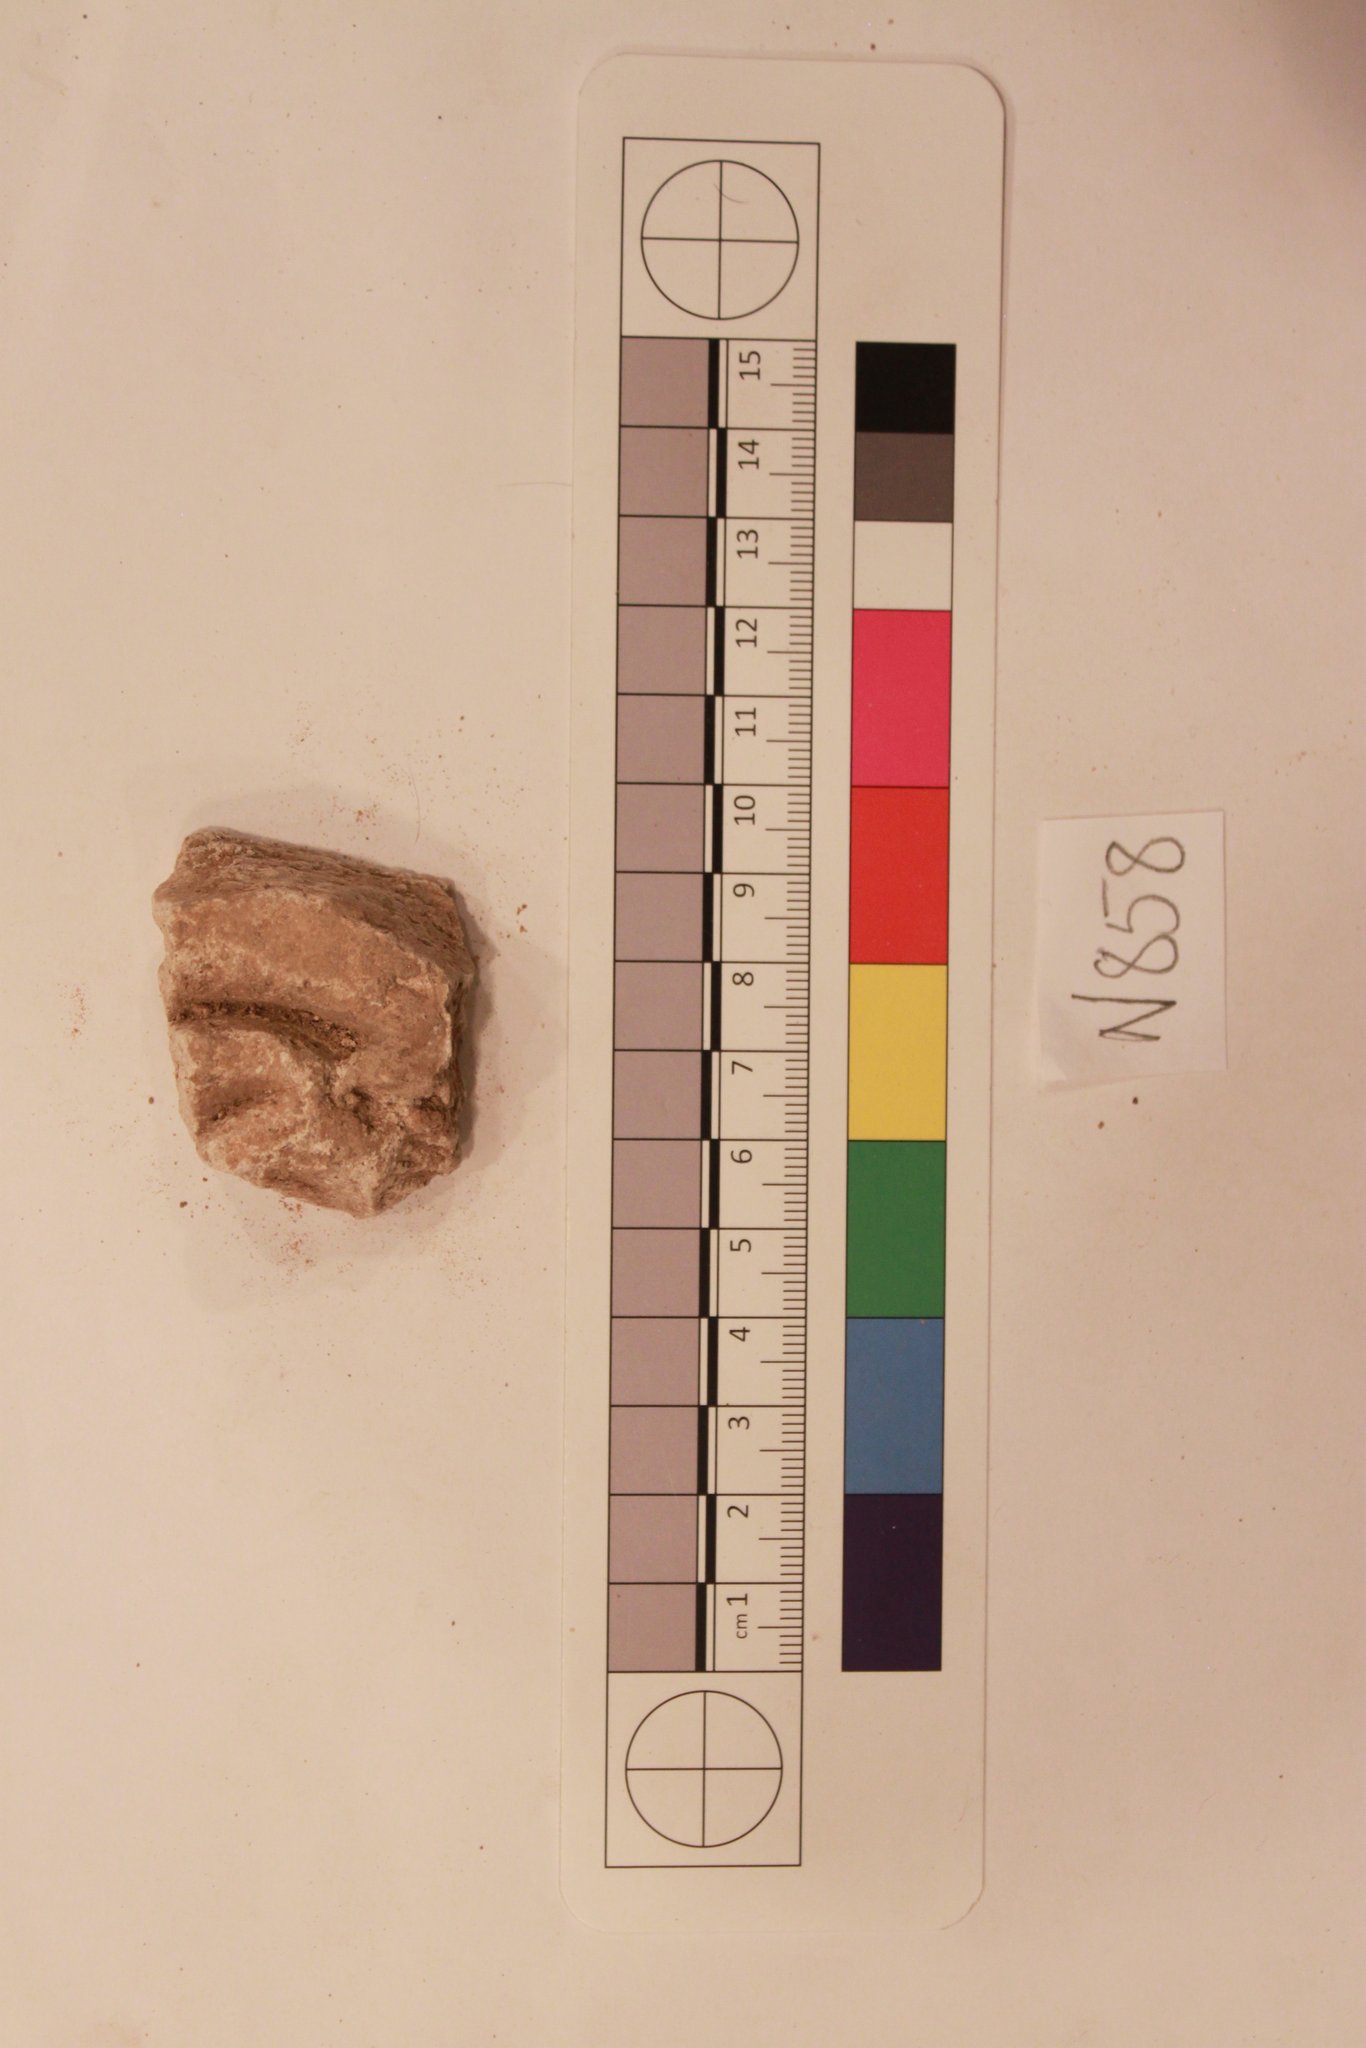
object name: fragment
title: Stucco Fragment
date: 701-1200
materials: plaster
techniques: carving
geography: iran